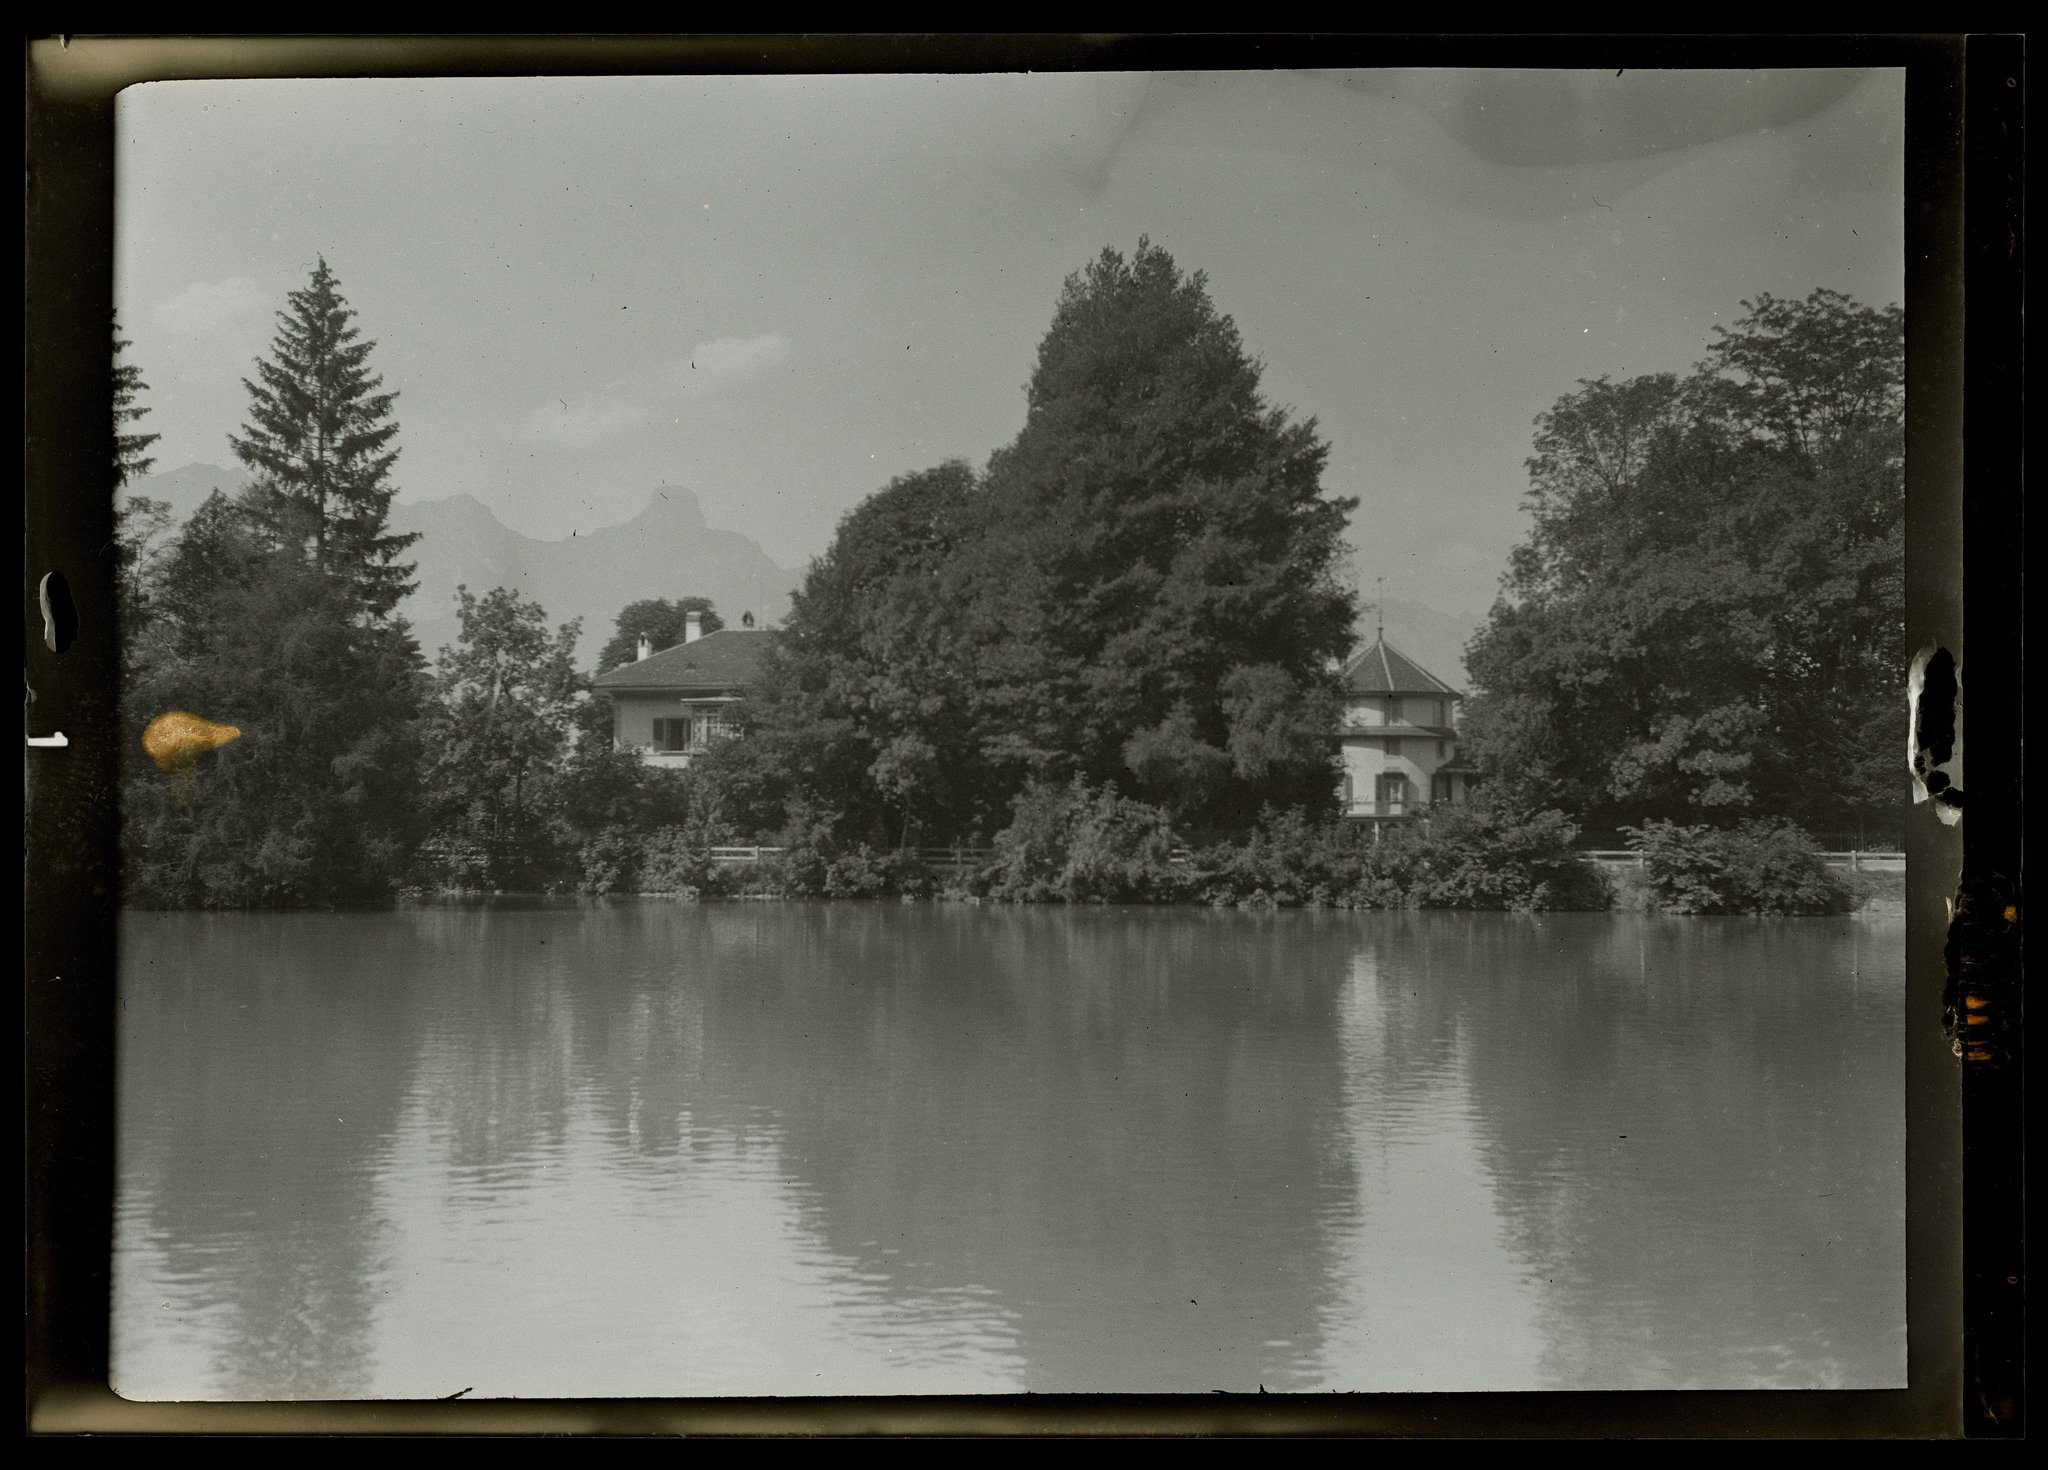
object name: negative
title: Filmnegatief met opname van Basel, Thun, Kandersteg of Gemmi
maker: Anonymous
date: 1921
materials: film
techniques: gelatin silver negative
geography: switzerland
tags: switzerland